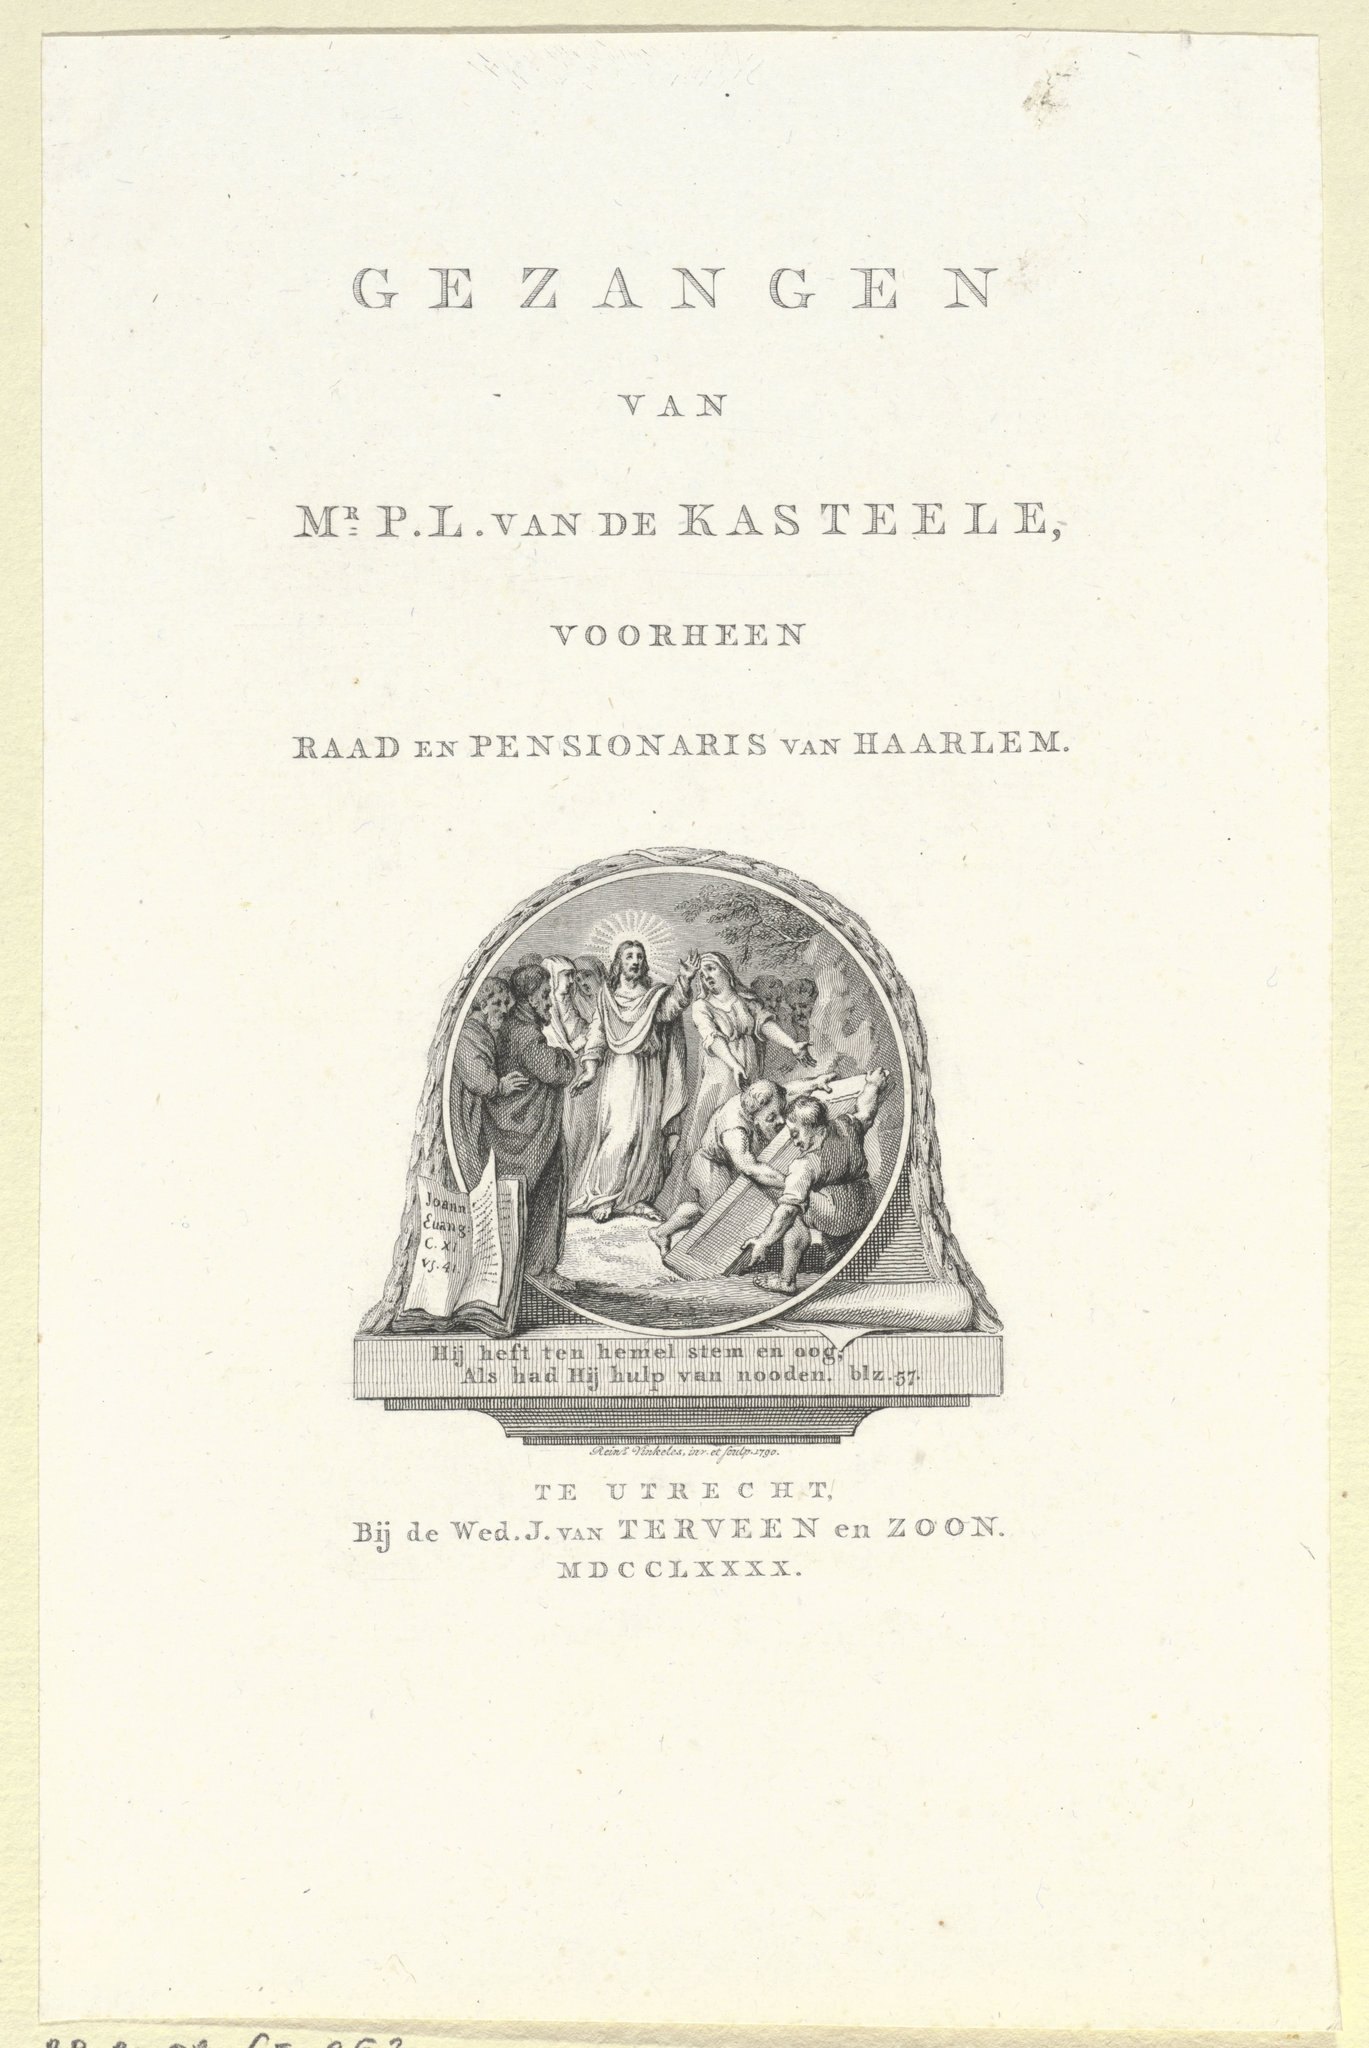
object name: titelblad, titelpagina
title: Titelpagina voor: P.L. van de Kasteele 'Gezangen', 1790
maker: reinier vinkeles (i)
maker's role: draughtsman, print maker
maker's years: 1741-1816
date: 1790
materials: paper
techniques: engraving, etching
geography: utrecht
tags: christ, grave, tomb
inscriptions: collector's mark: Lugt 240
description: Titelpagina voor: Kasteele, P.L. van de. Gezangen. Utrecht: weduwe Jan van Terveen & Zoon, 1790.